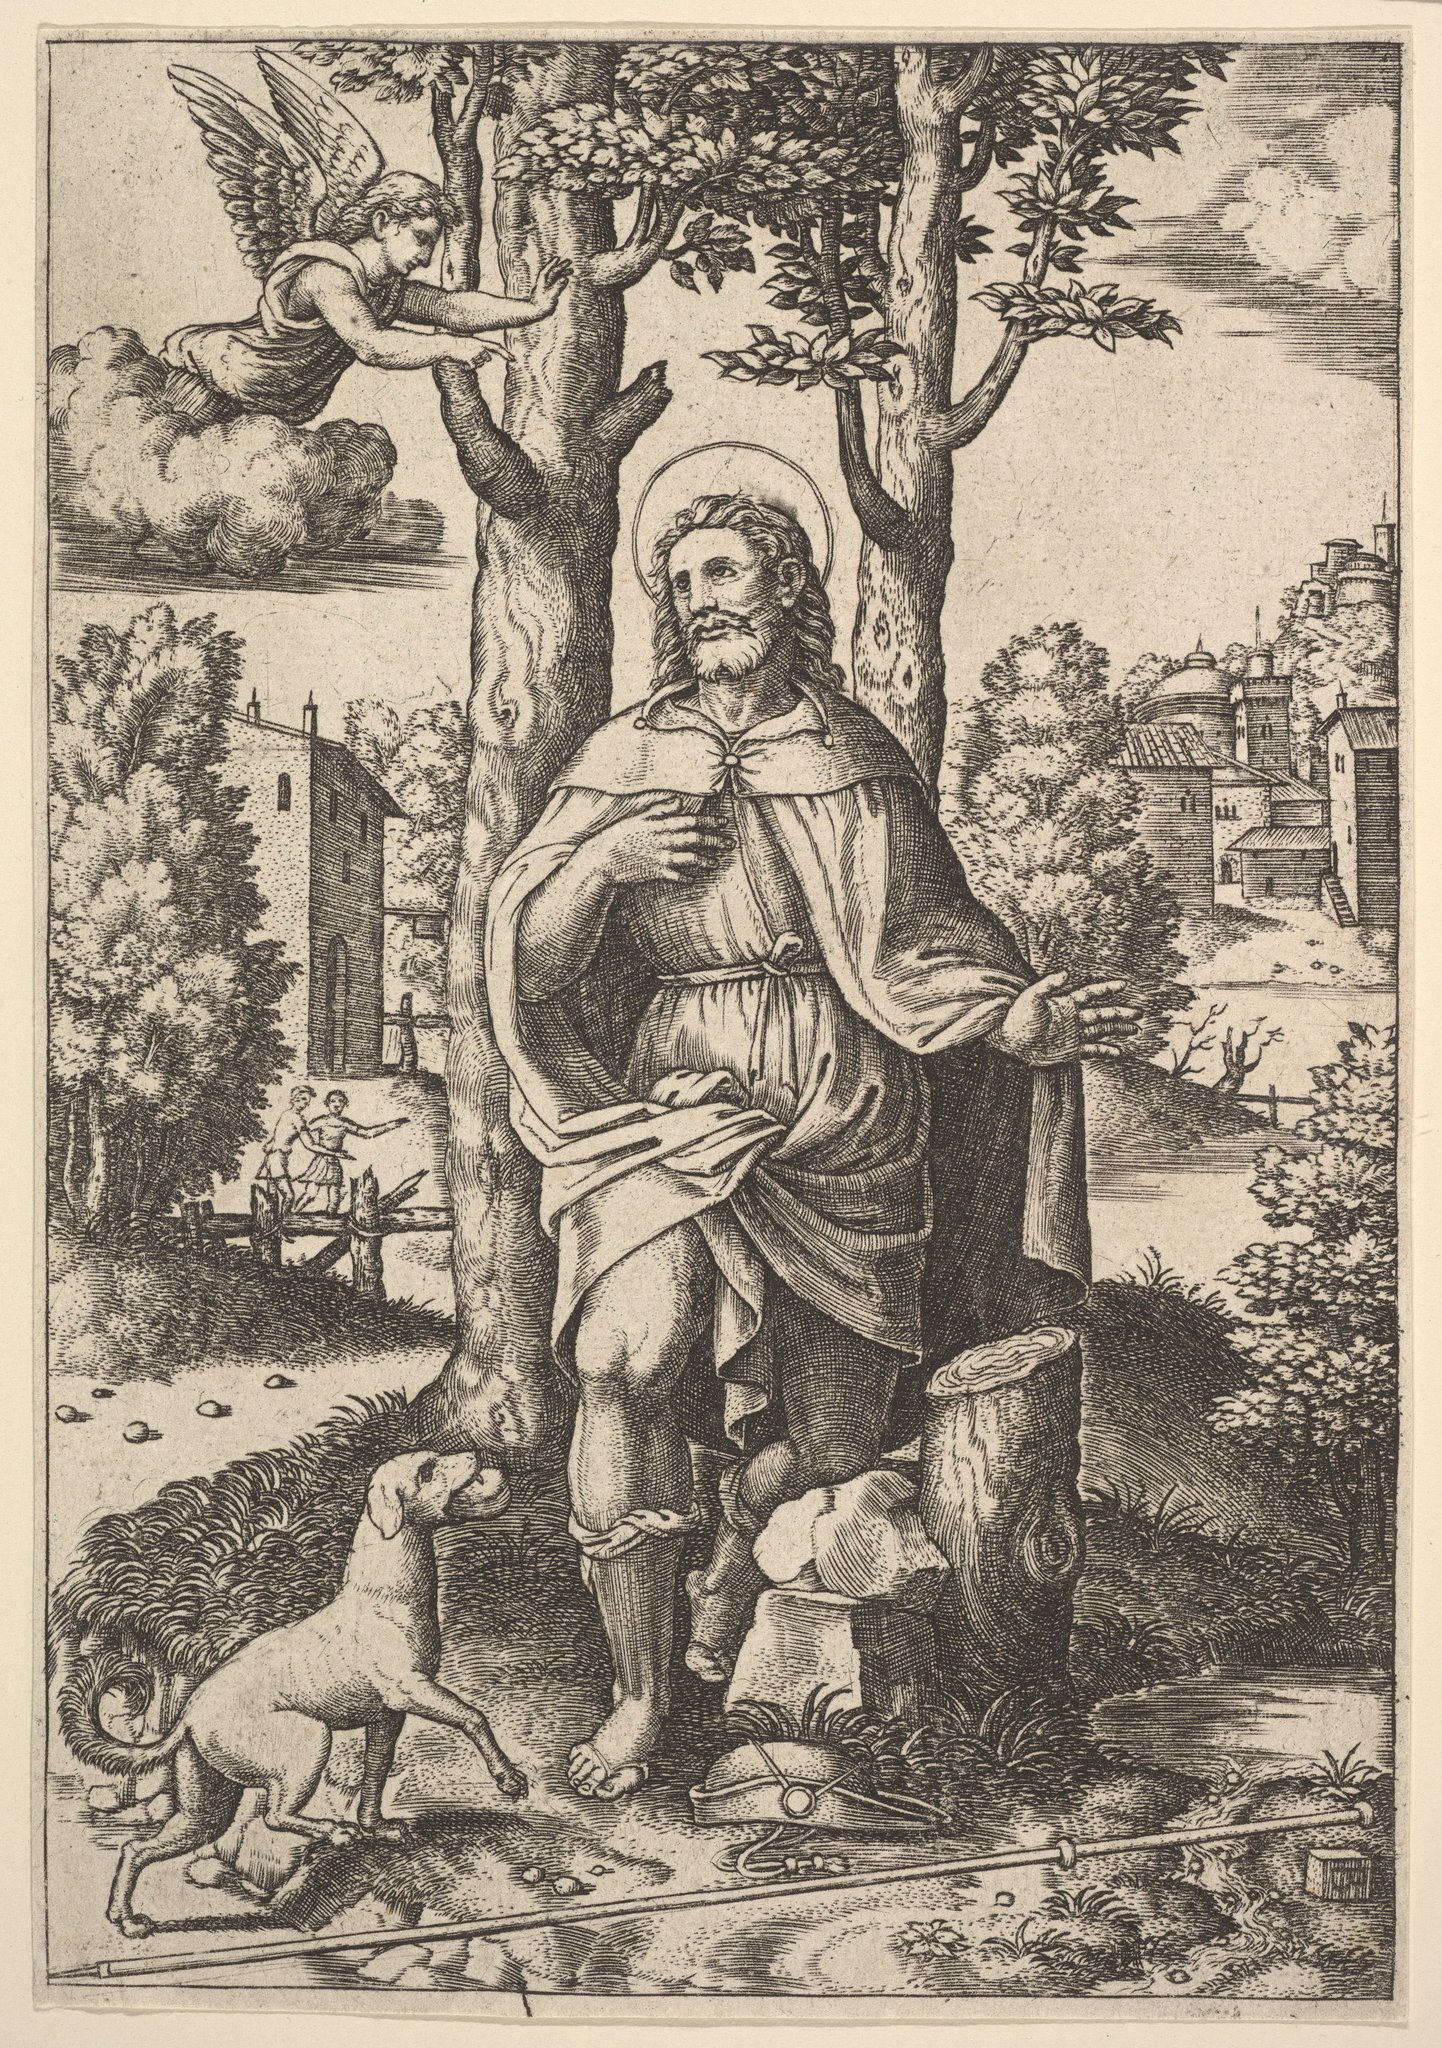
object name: print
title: Saint Roch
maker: master of the die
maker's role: artist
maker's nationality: italian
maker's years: 1525-1560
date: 1520-1570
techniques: engraving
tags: men,dogs,angels,saints